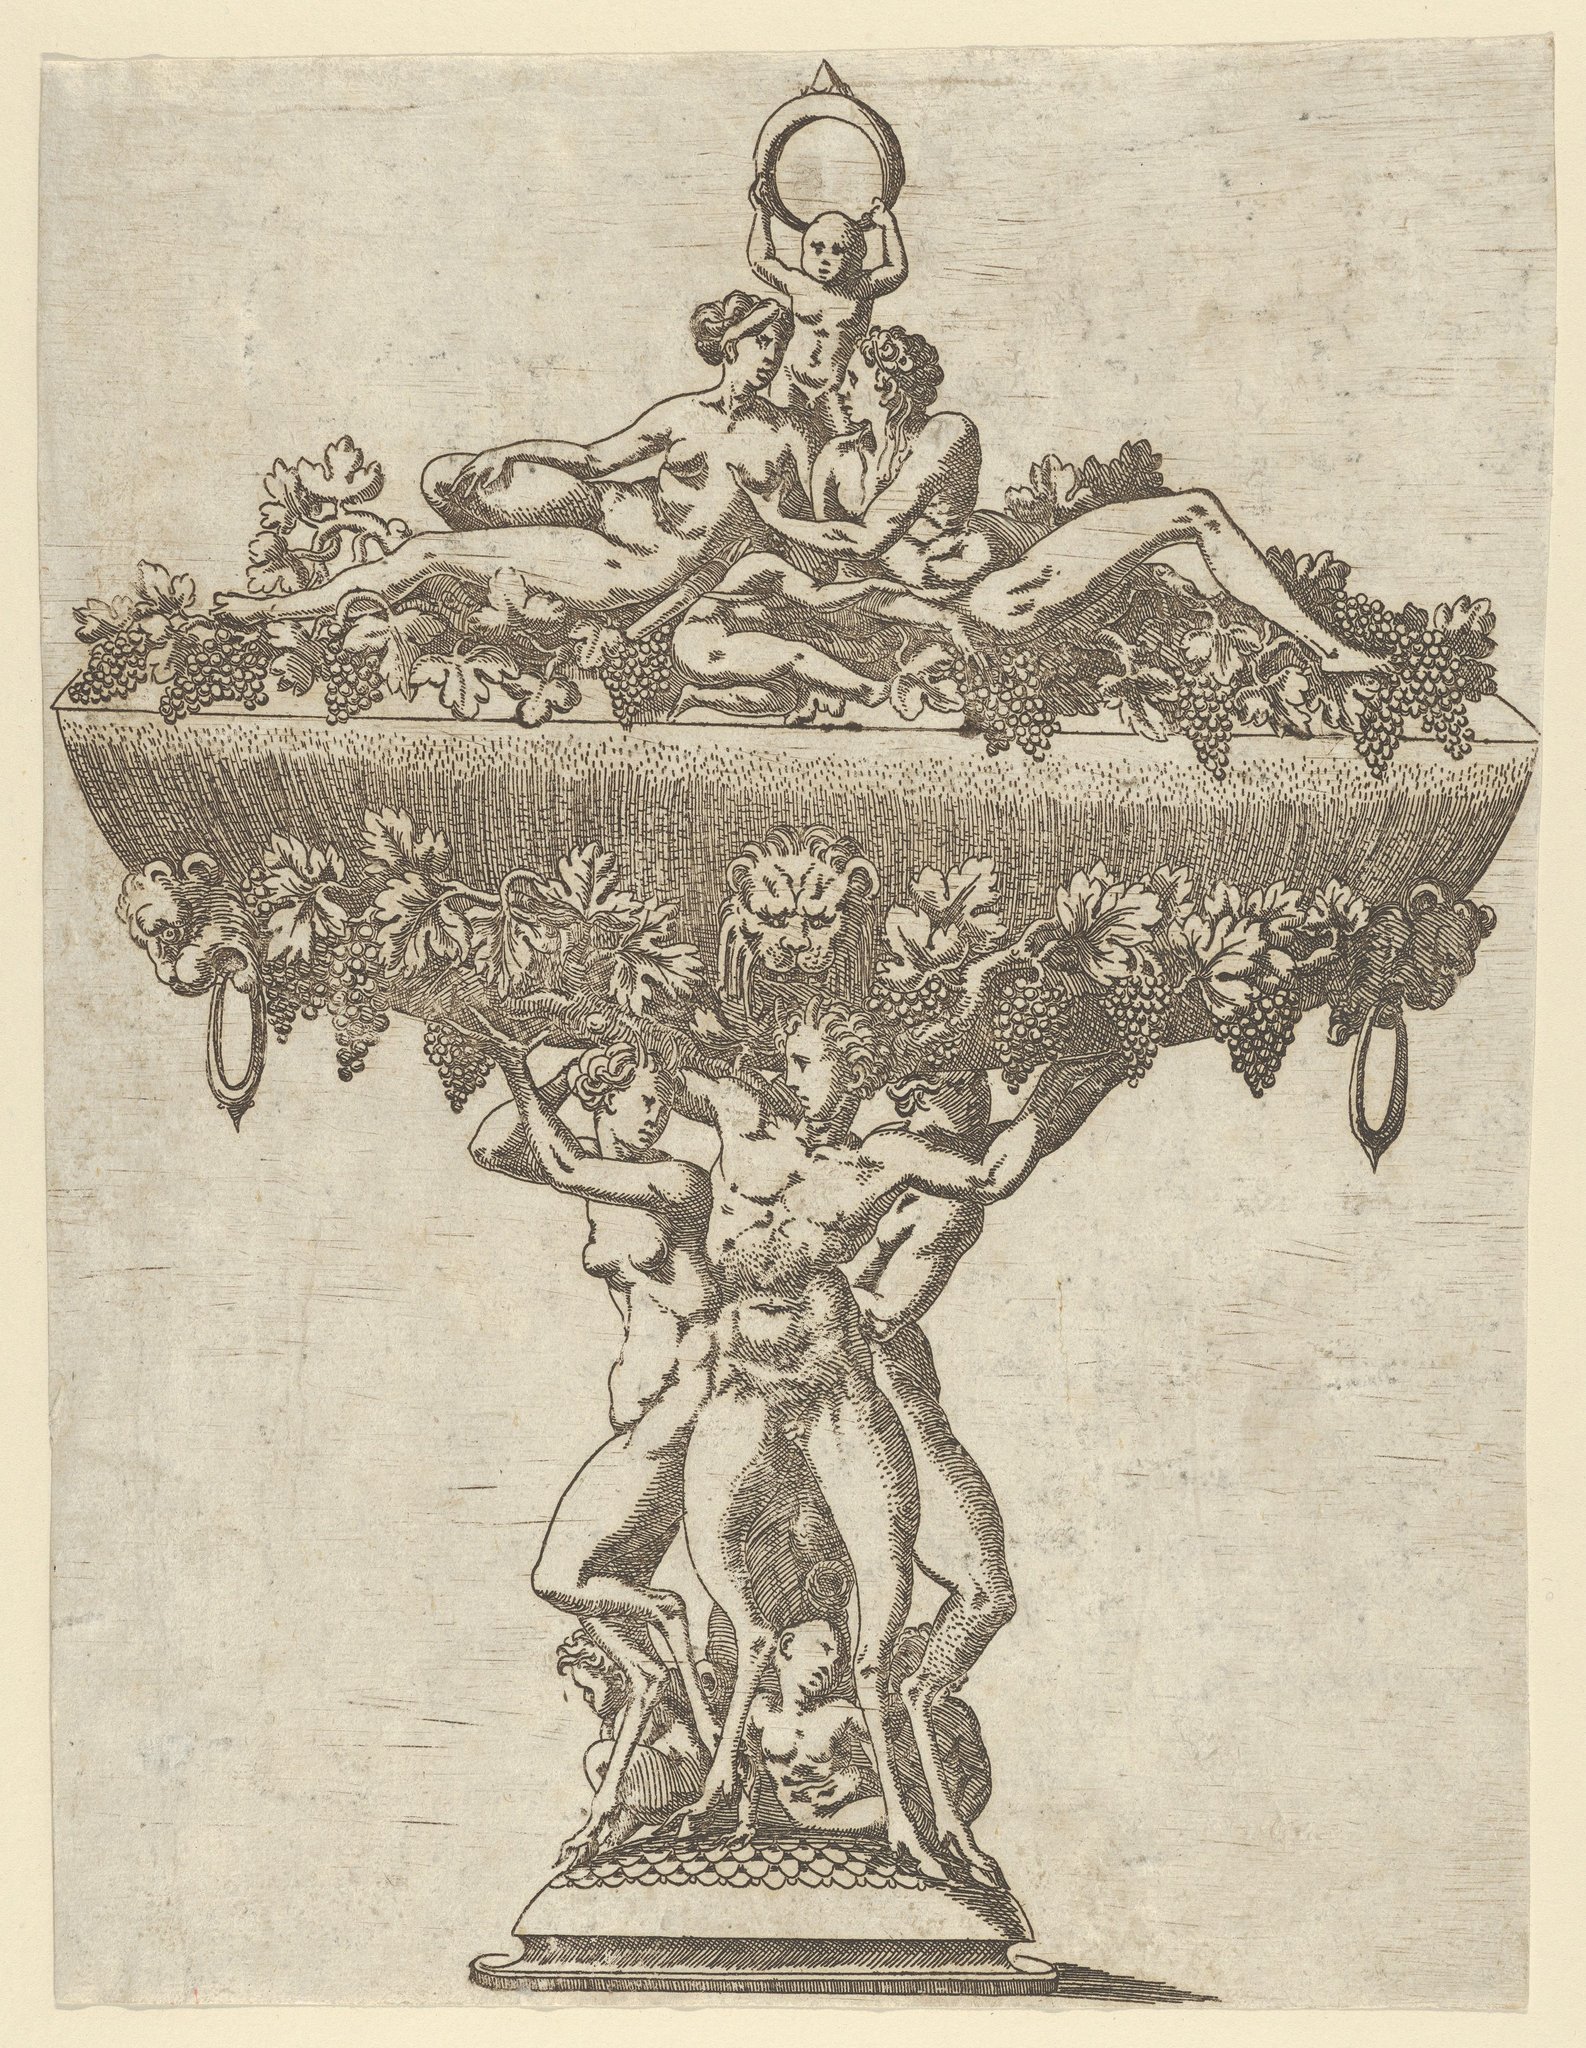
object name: print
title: Vase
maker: antonio fantuzzi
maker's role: artist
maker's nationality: italian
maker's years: 1537-1545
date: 1543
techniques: etching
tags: grapes,male nudes,female nudes,vases